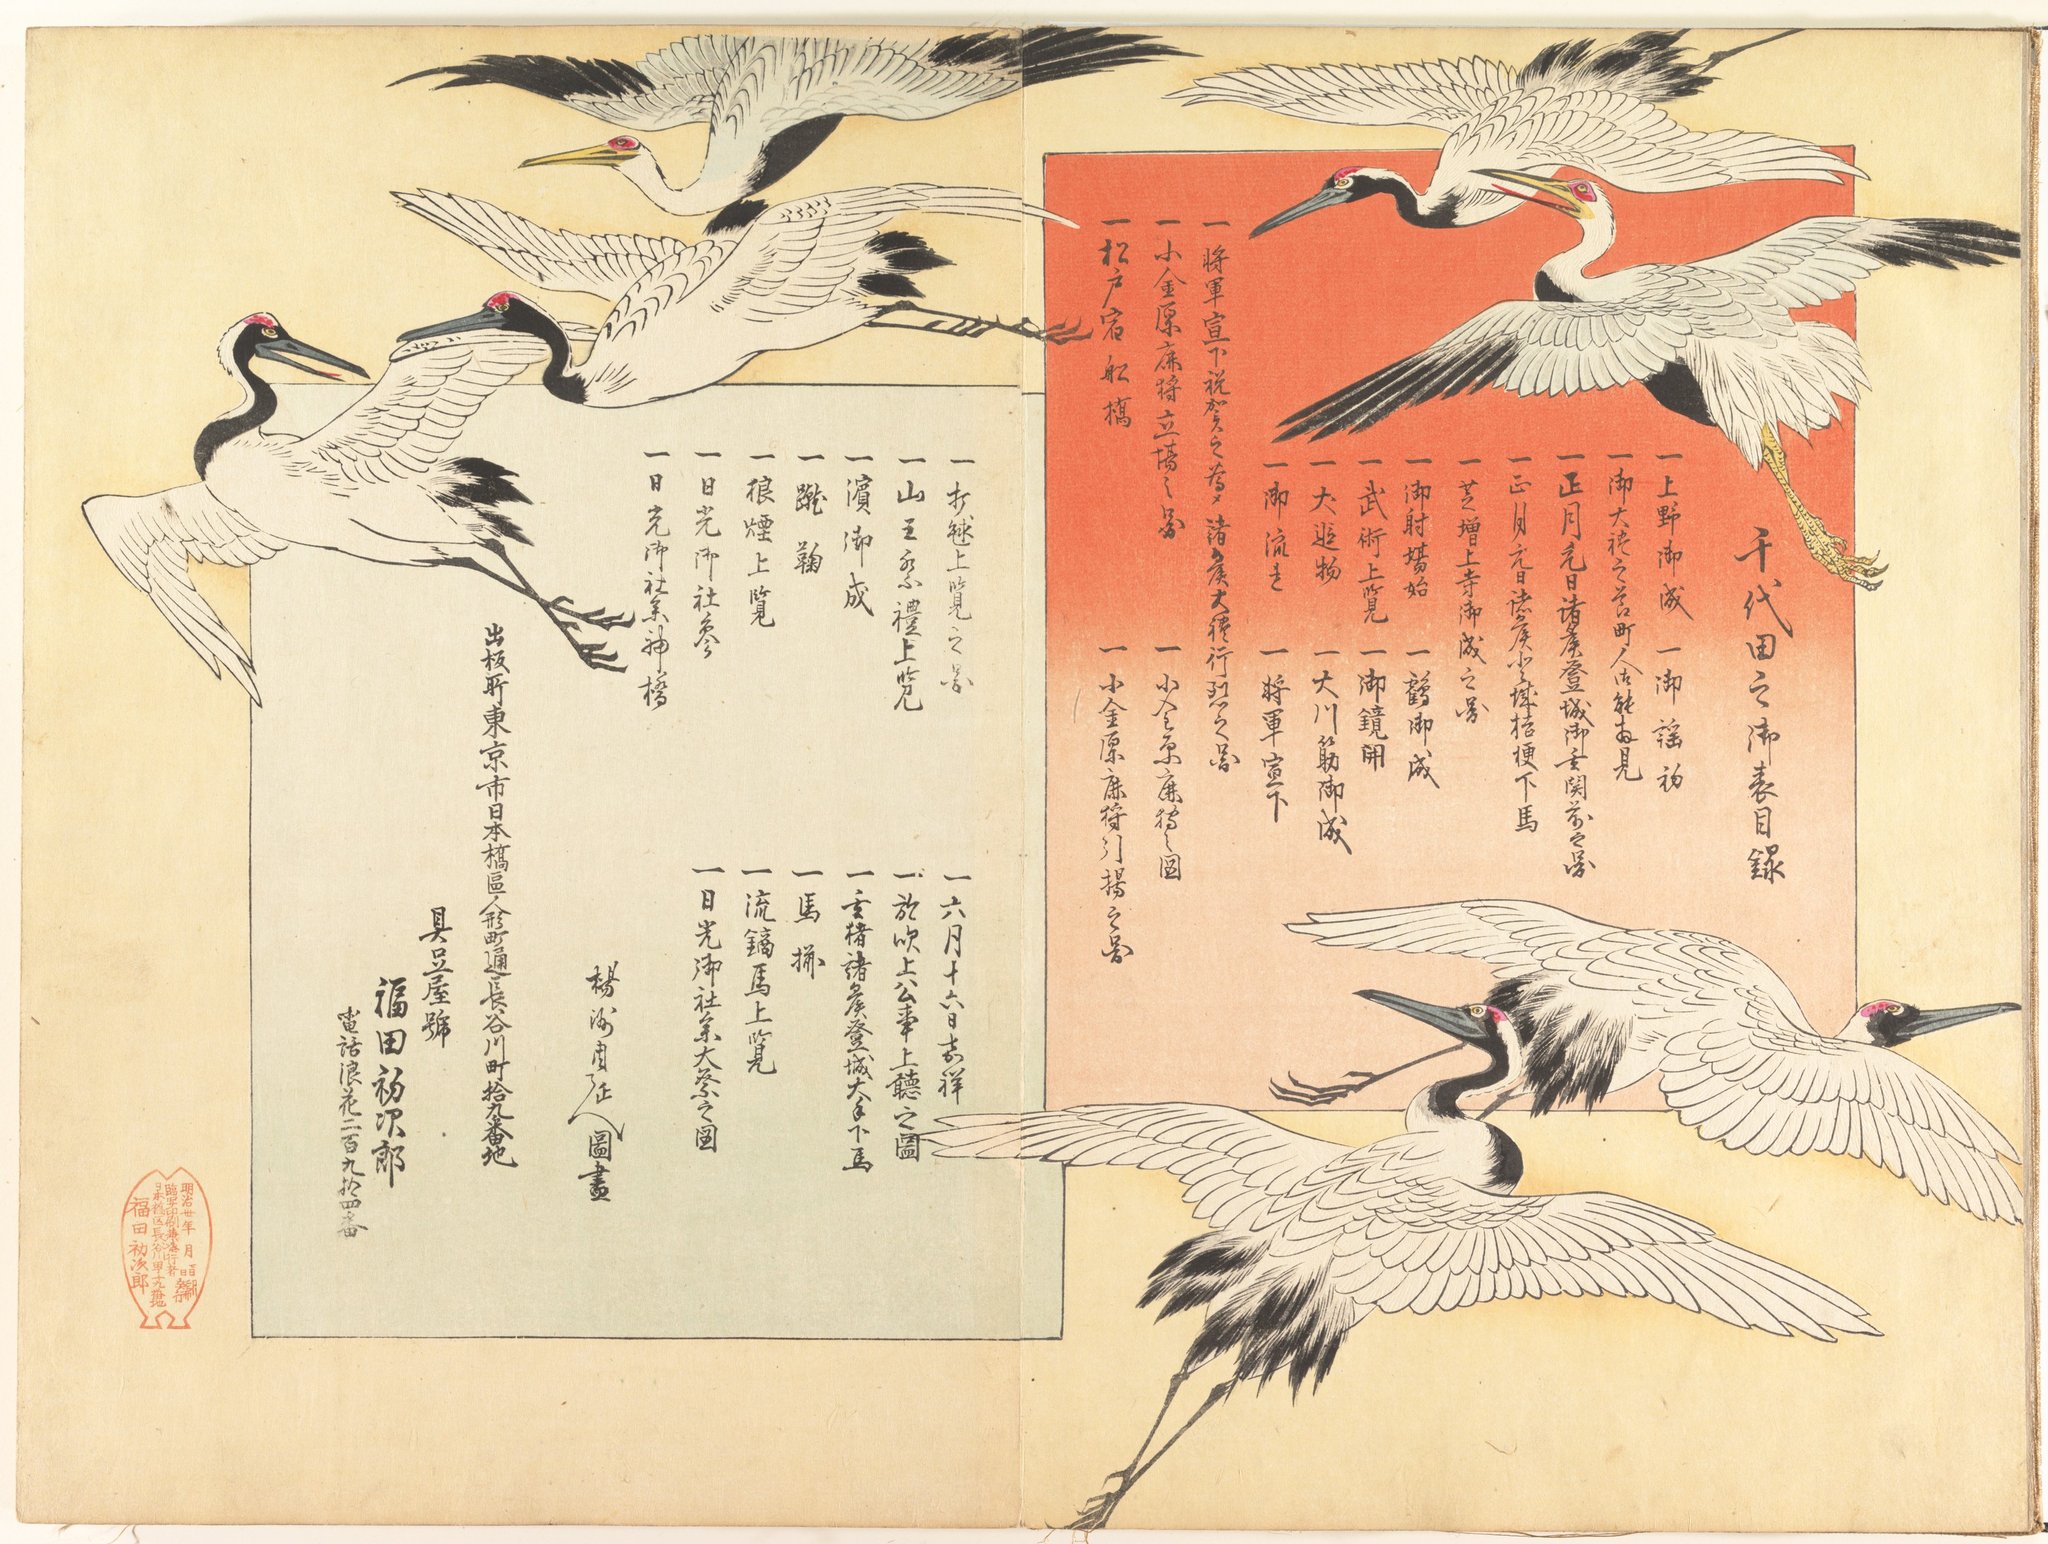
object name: print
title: Chiyoda Castle (Album of Men)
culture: japanese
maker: yōshū (hashimoto) chikanobu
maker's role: artist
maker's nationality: japanese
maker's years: 1838-1912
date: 1897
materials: ink, paper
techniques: woodblock print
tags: birds